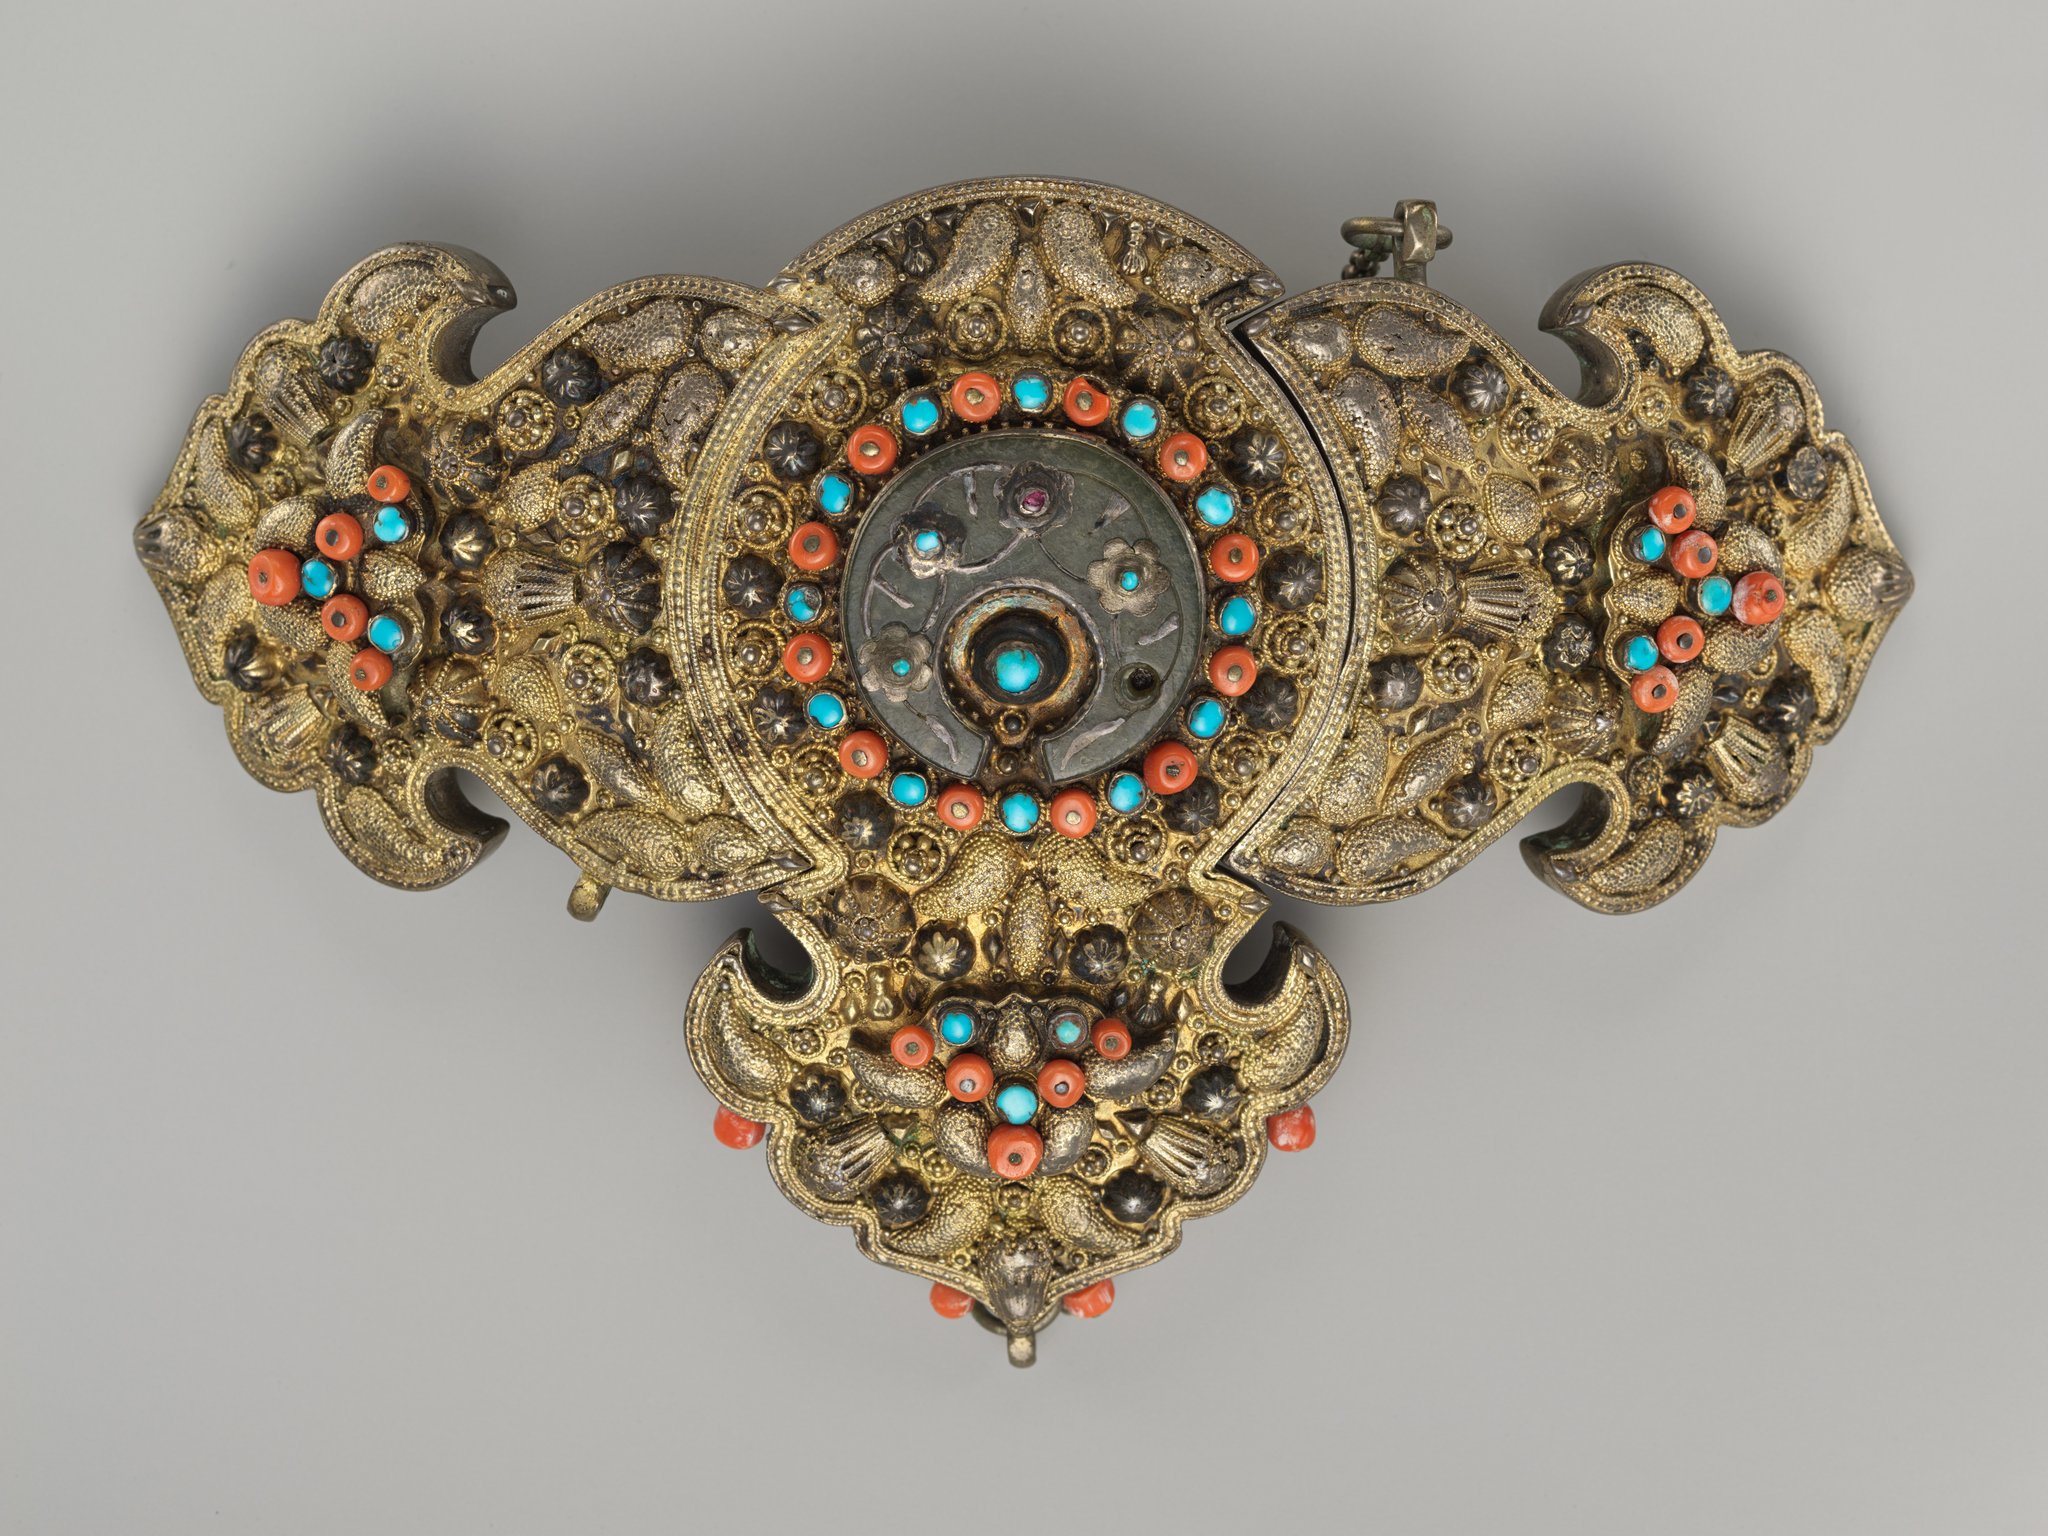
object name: girdle clasp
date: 1801-1900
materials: coral, gilt, silver, metal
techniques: inlay, repoussé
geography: turkey